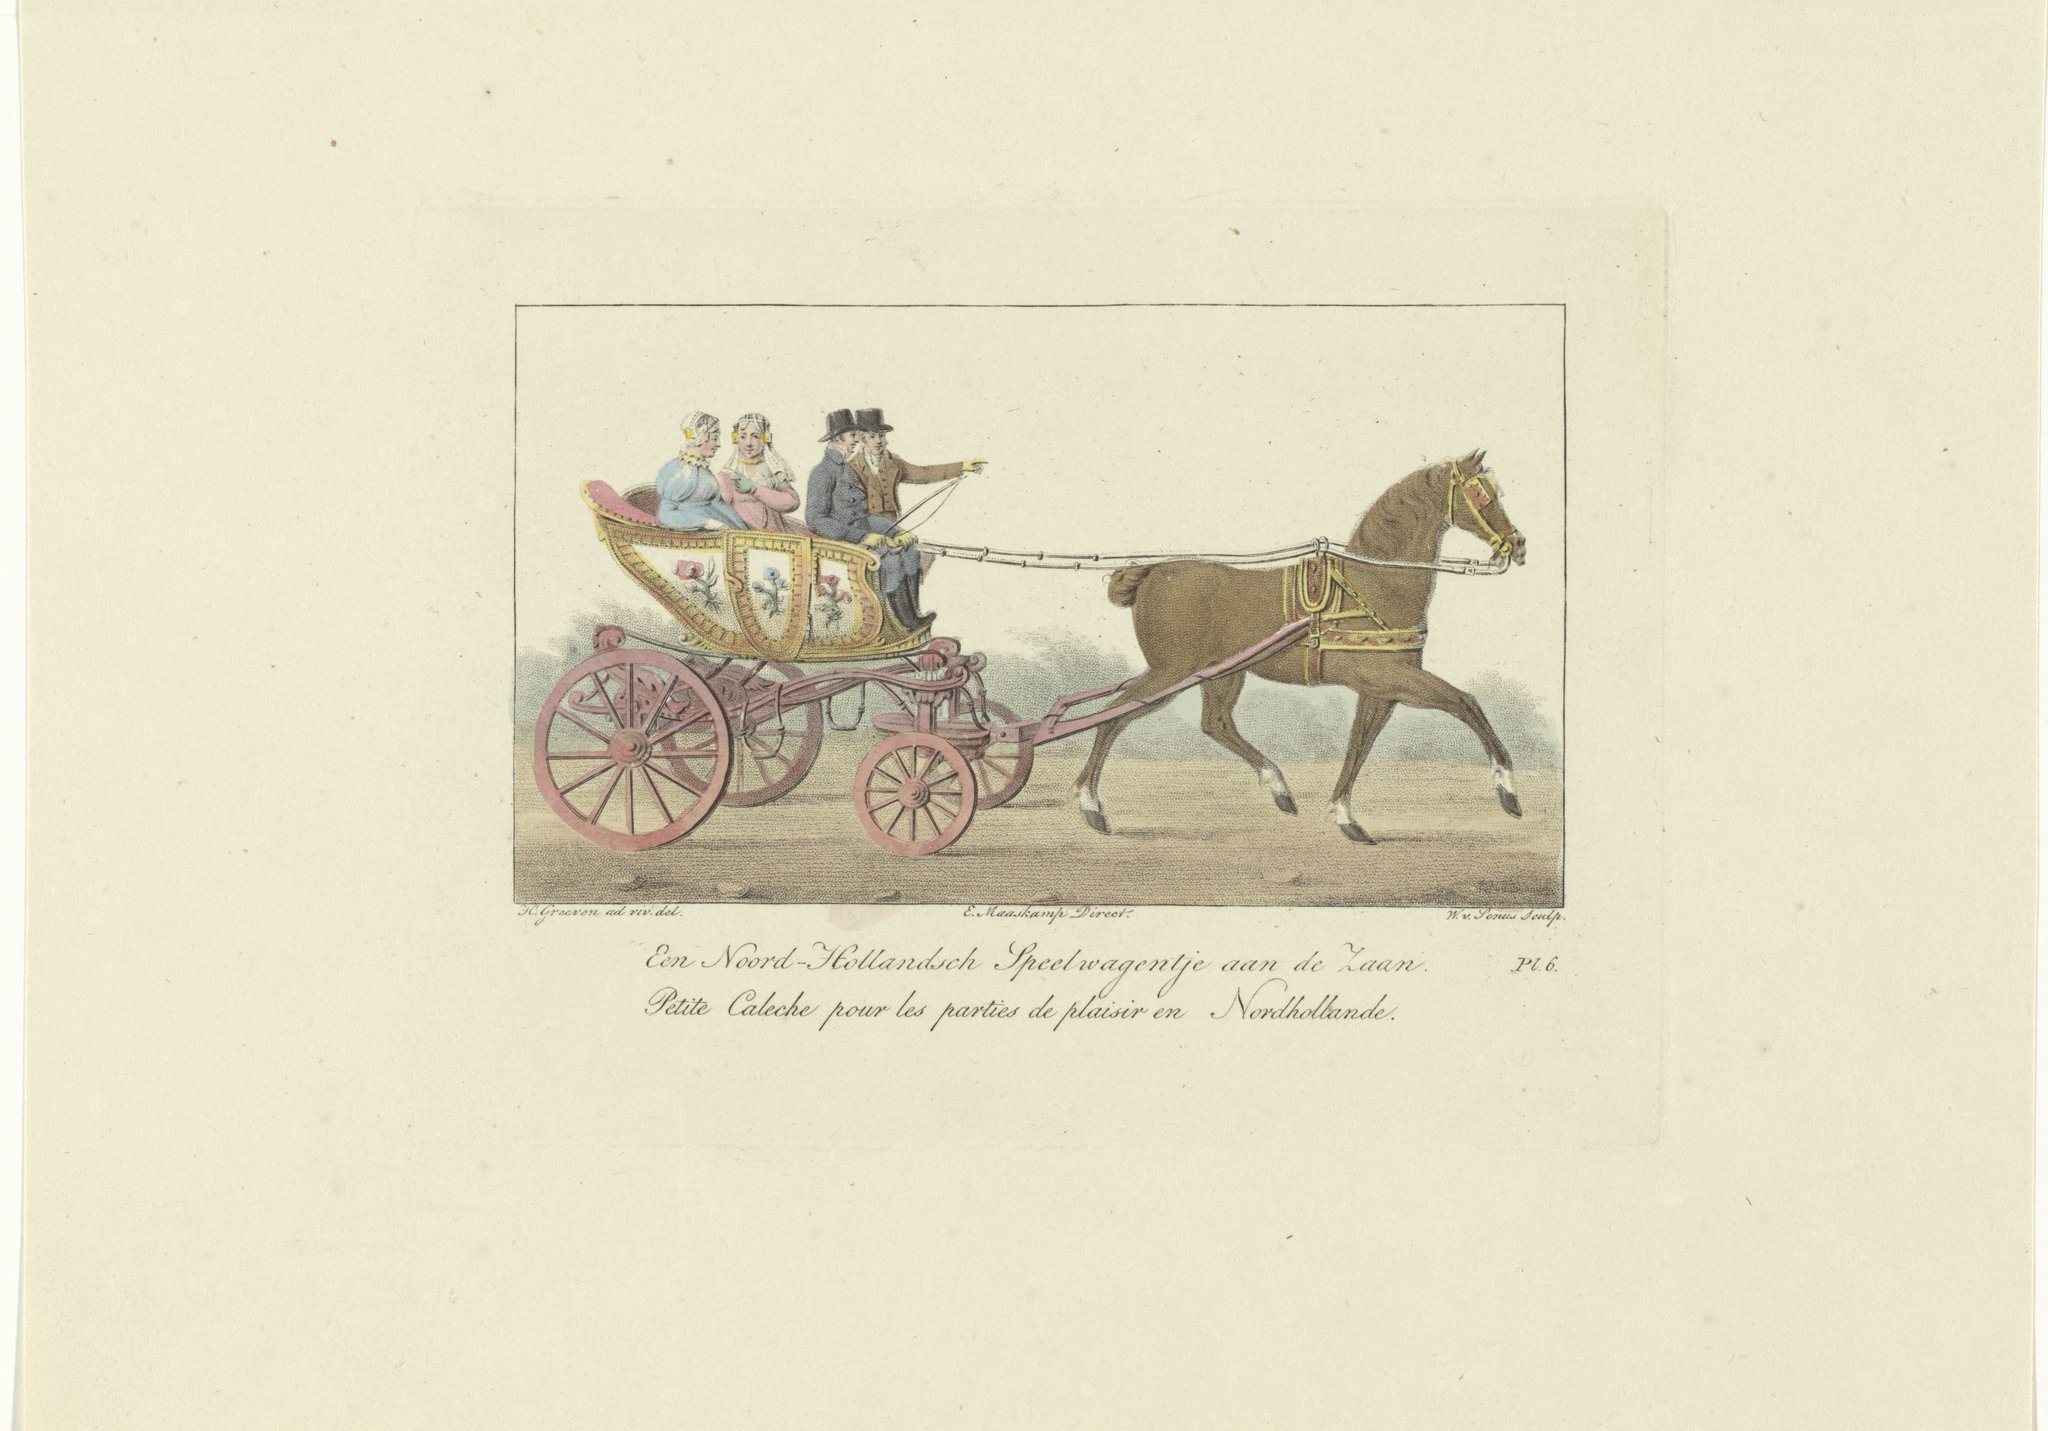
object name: print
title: Een Noord-Hollandsch Speelwagentje aan de Zaan/ Petite Caleche pour les parties de plaisir en Nordhollande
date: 1824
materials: paper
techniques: etching, hand coloring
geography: amsterdam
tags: four-wheeled vehicle drawn by one animal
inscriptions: collector's mark: Lugt 2228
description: Prent gebruikt in: Maaskamp, Evert. Tableau des principales vues des palais et édifices : représentations et des coutumes et usages, dans les provinces septentrionales du Royaume des Pays-Bas. Amsterdam, 1824.